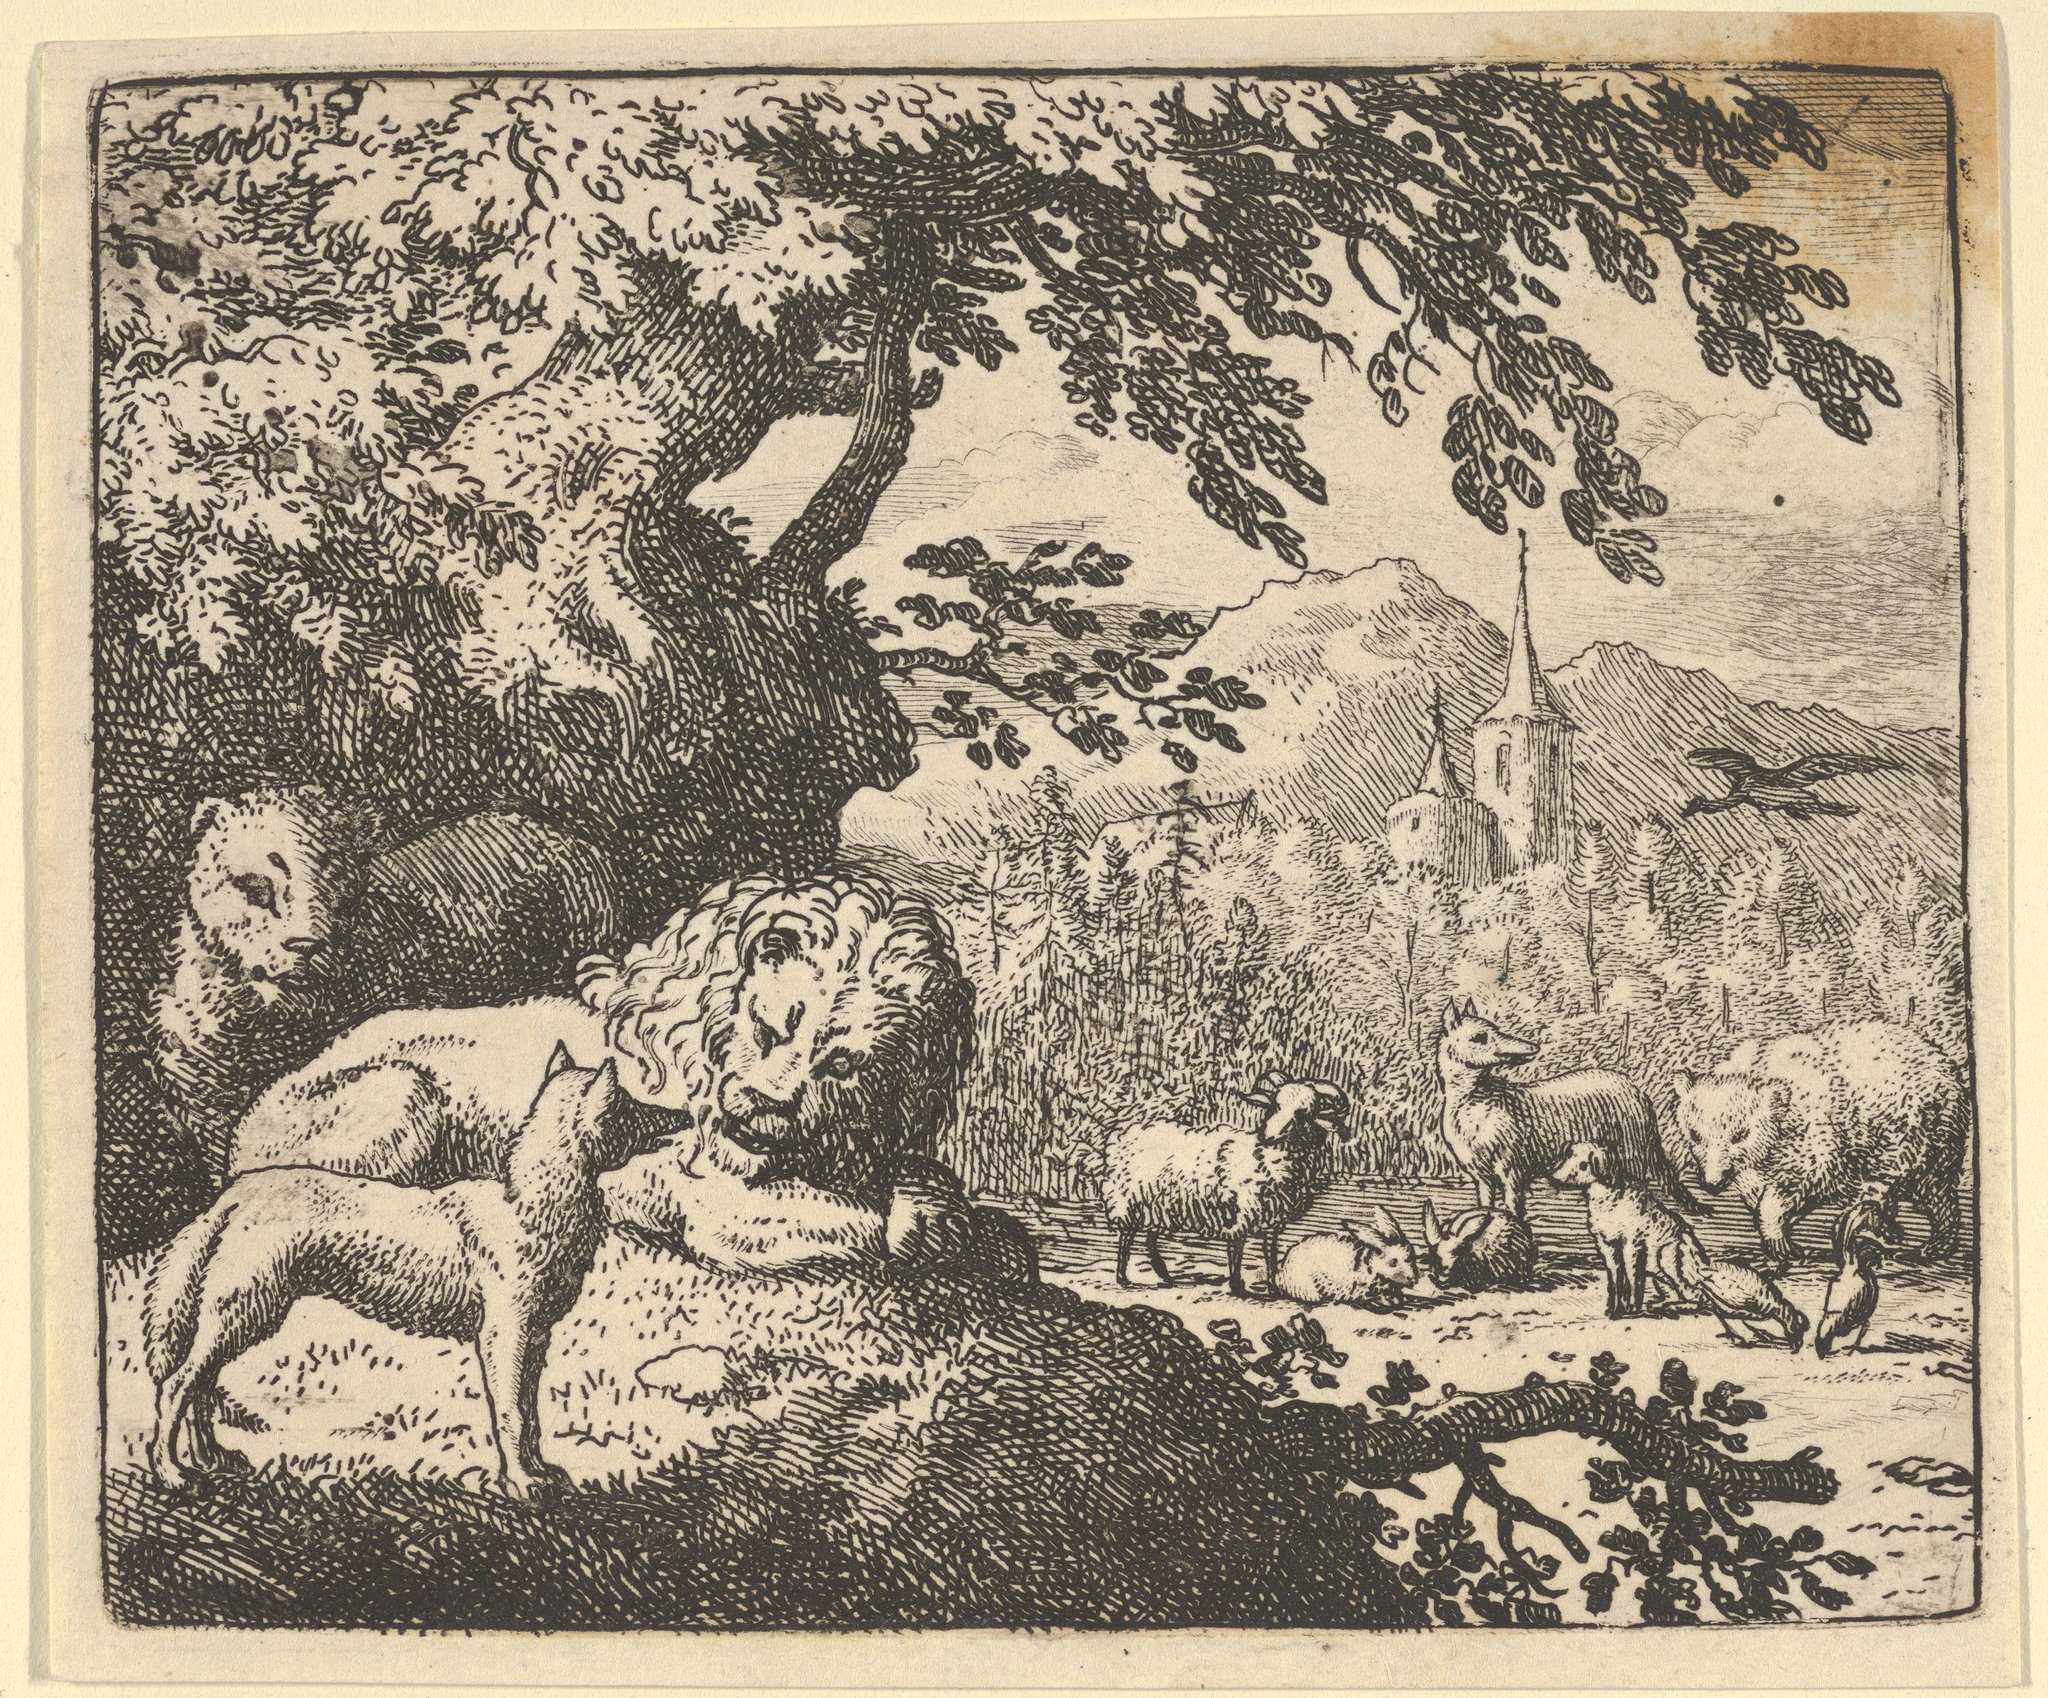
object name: print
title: Renard Continues with His Lies from Hendrick van Alcmar's Renard The Fox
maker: allart van everdingen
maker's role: artist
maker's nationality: dutch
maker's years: 1621-1675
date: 1650-1675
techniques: engraving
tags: bears,birds,foxes,lions,rabbits